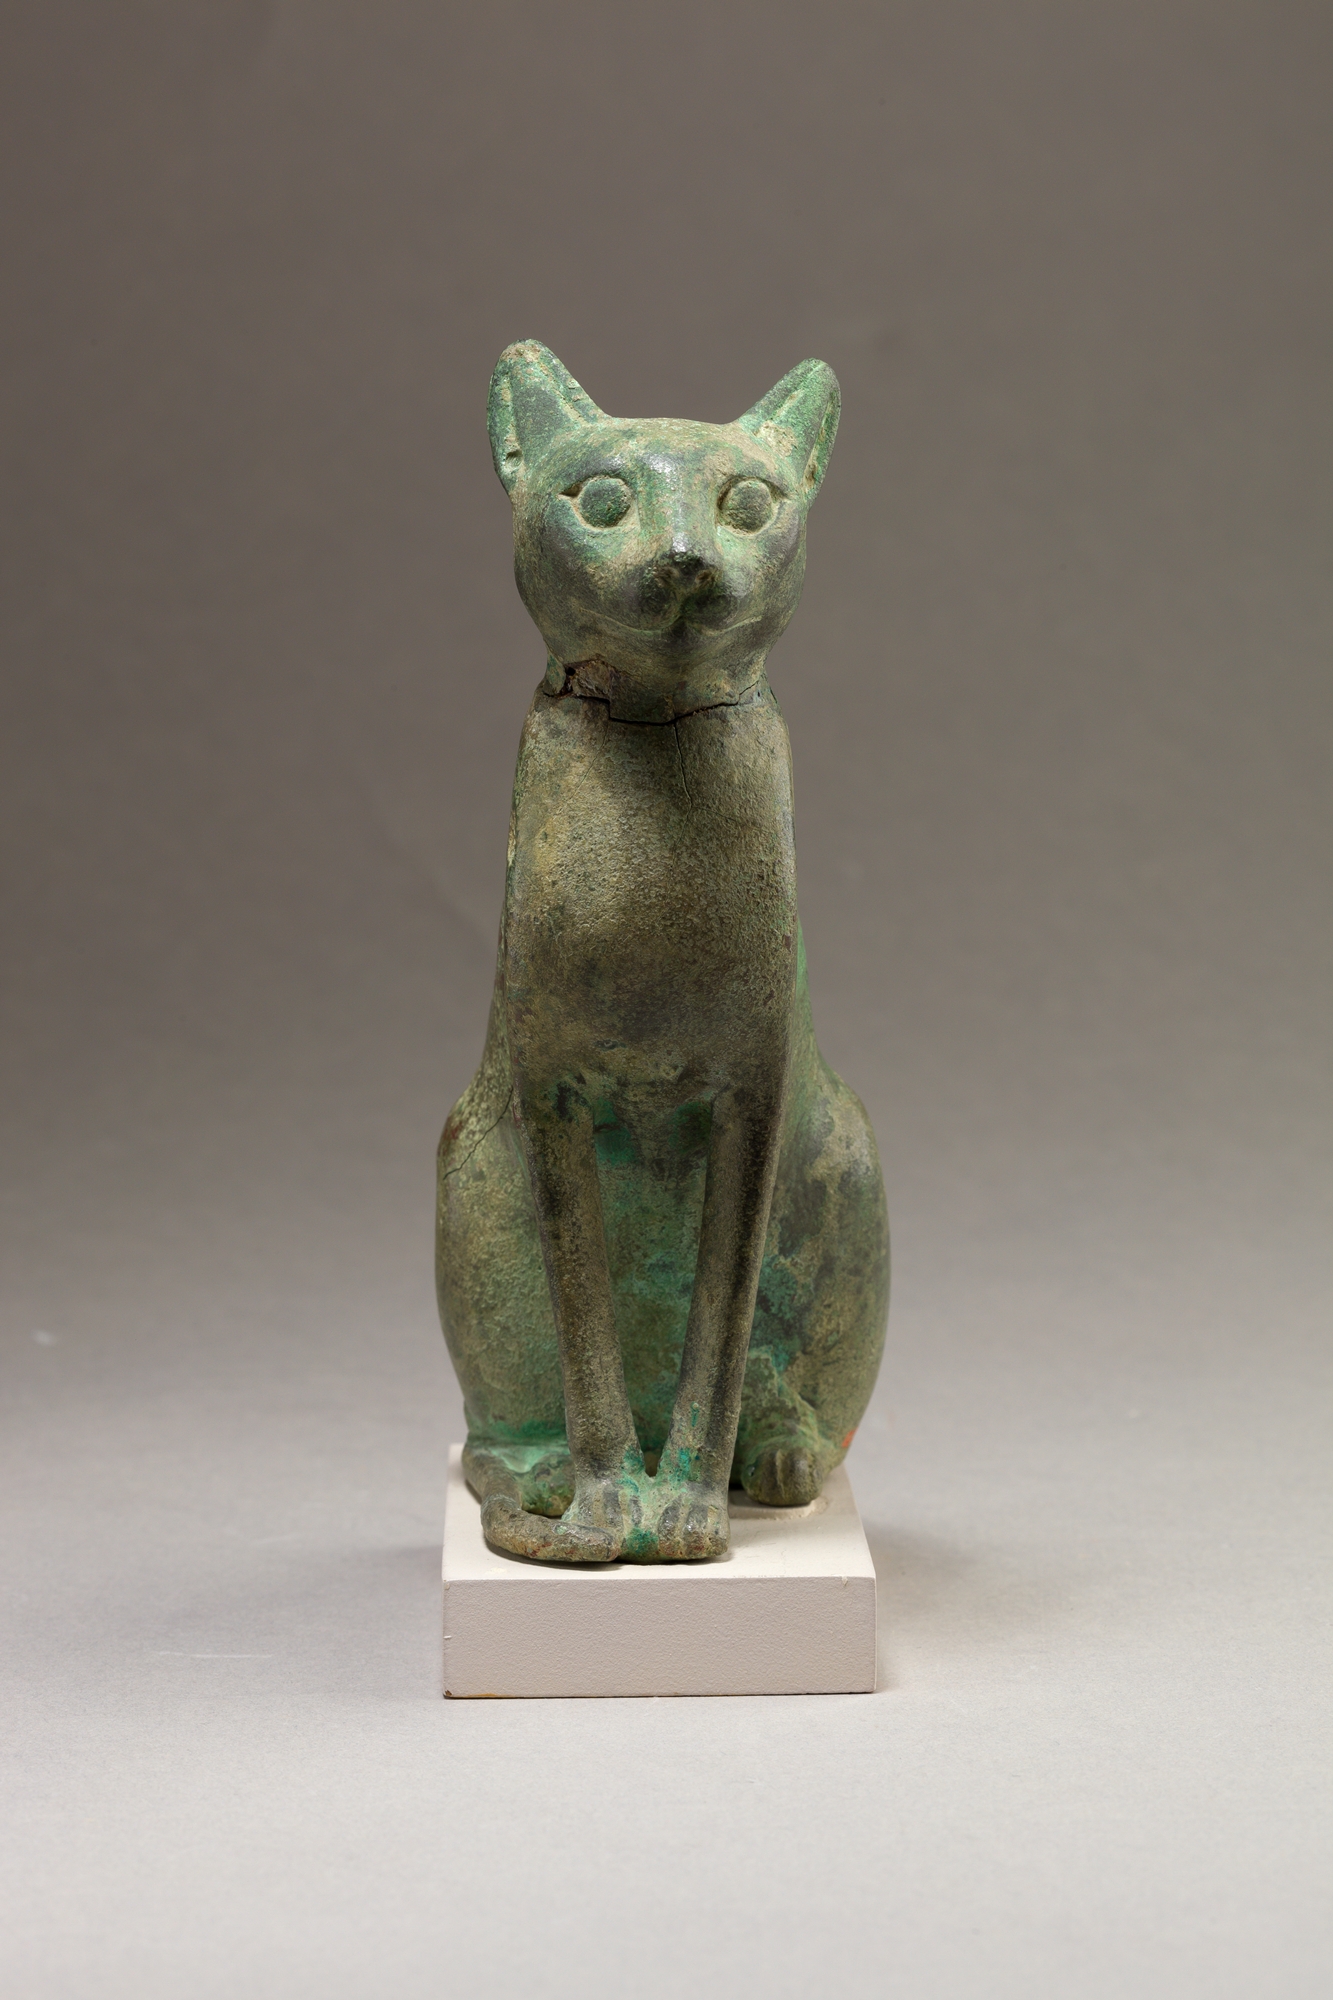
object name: figurine, cat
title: Cat Statuette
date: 664-630 BCE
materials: metal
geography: egypt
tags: cats